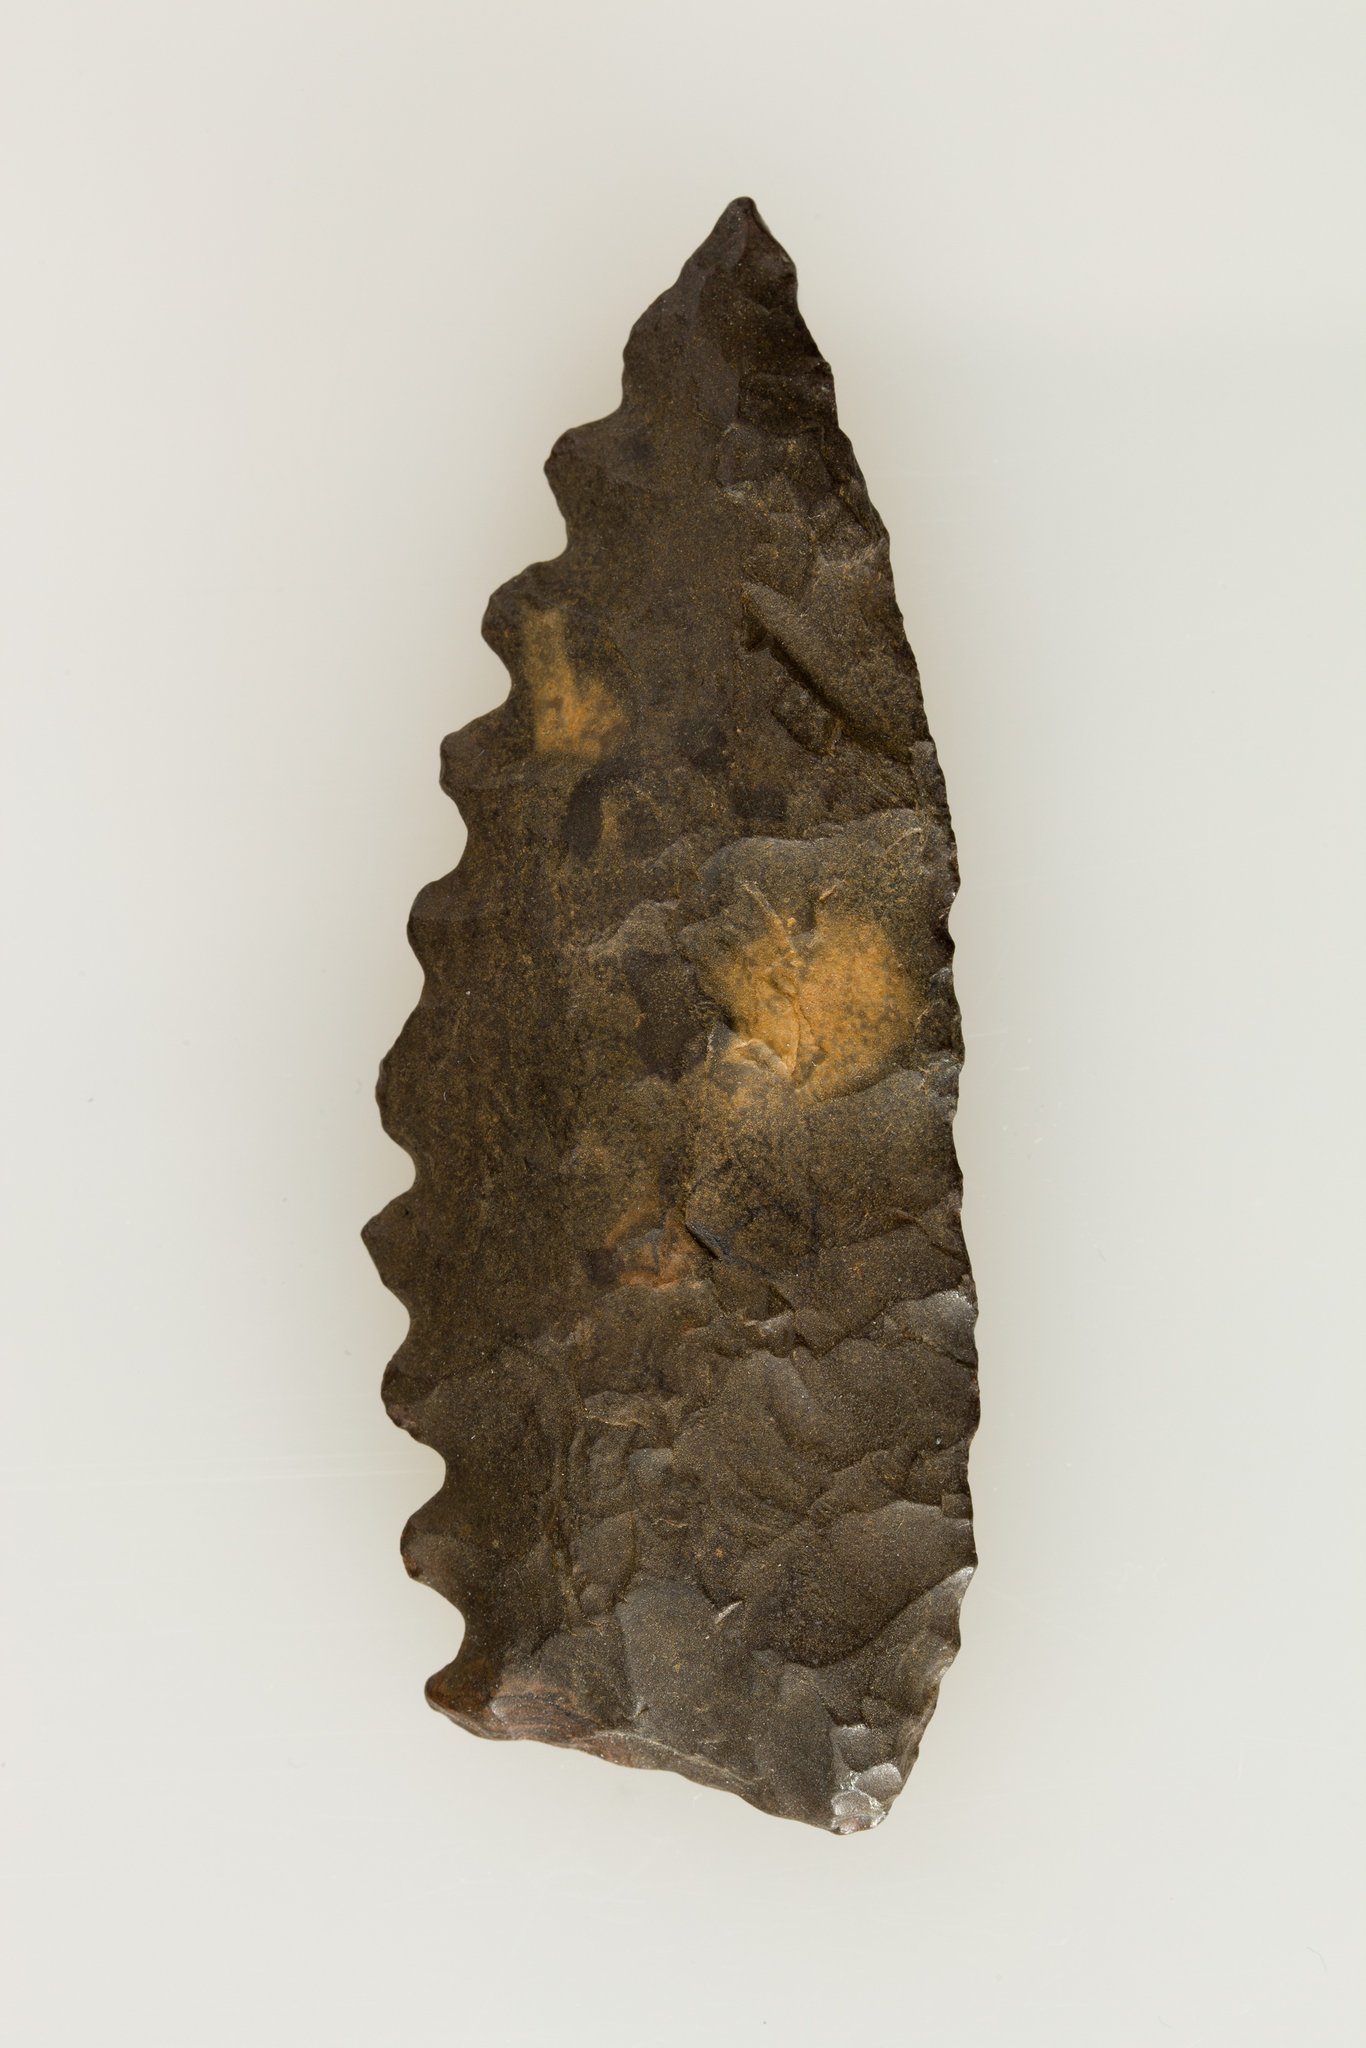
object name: sickle, insert, denticulate, bifacial, tool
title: Bifacial Sickle Insert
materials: stone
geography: egypt